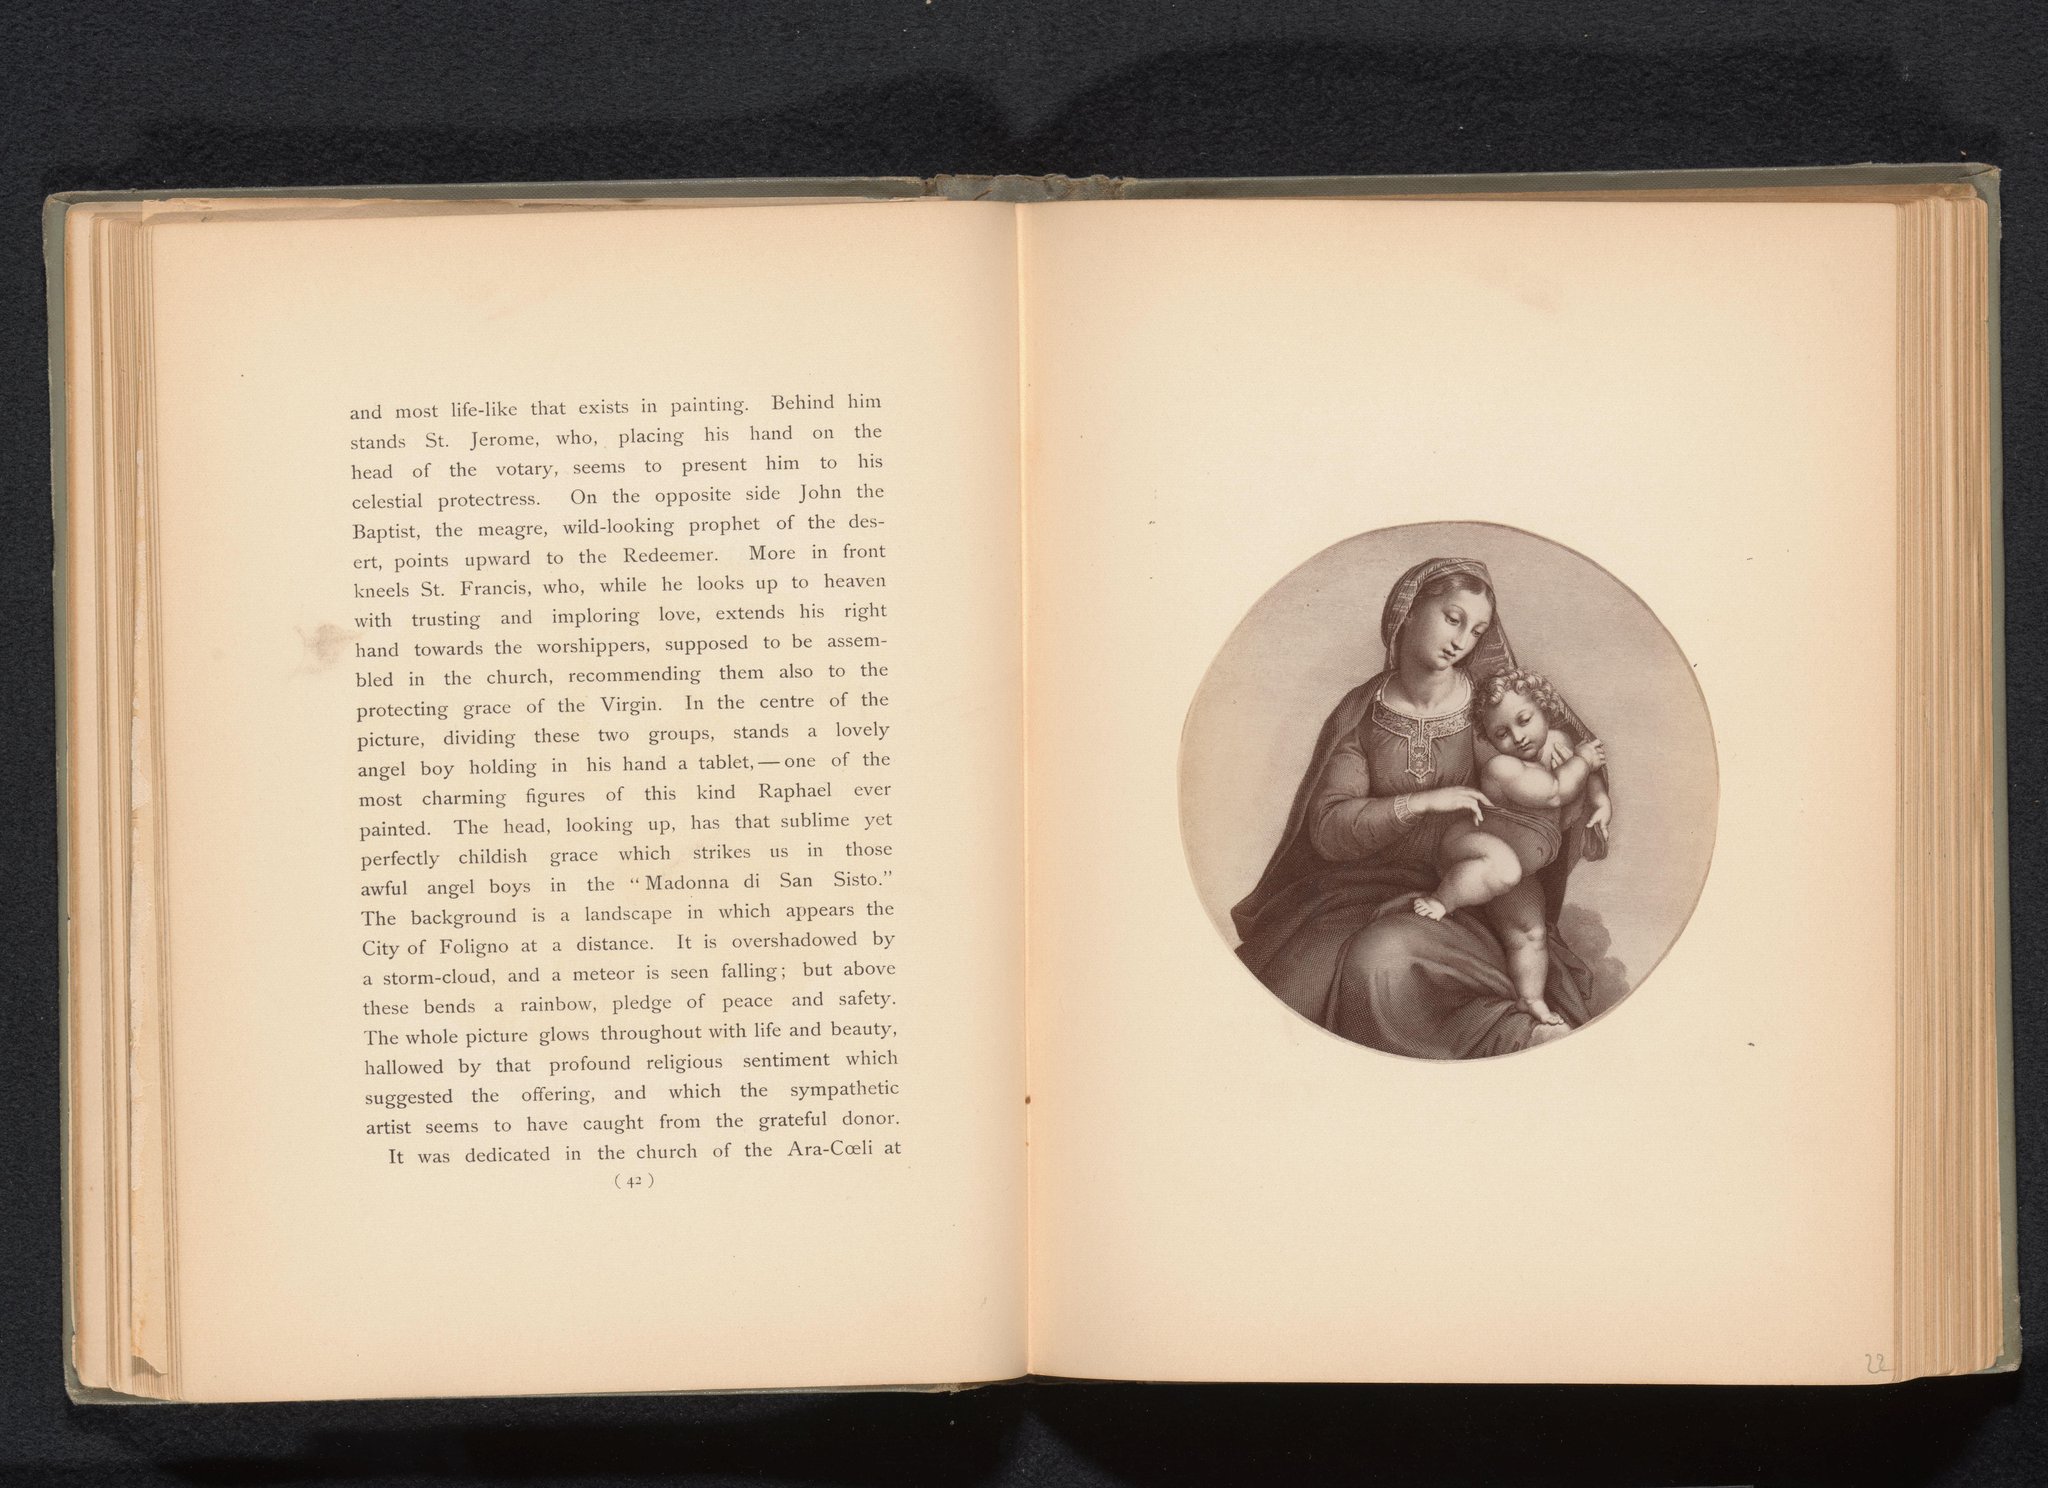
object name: photograph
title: Fotoreproductie van een prent naar het schilderij Madonna di Foligno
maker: Anonymous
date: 1882-1887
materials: photographic support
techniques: albumen print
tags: madonna: i.e. mary with the christ-child